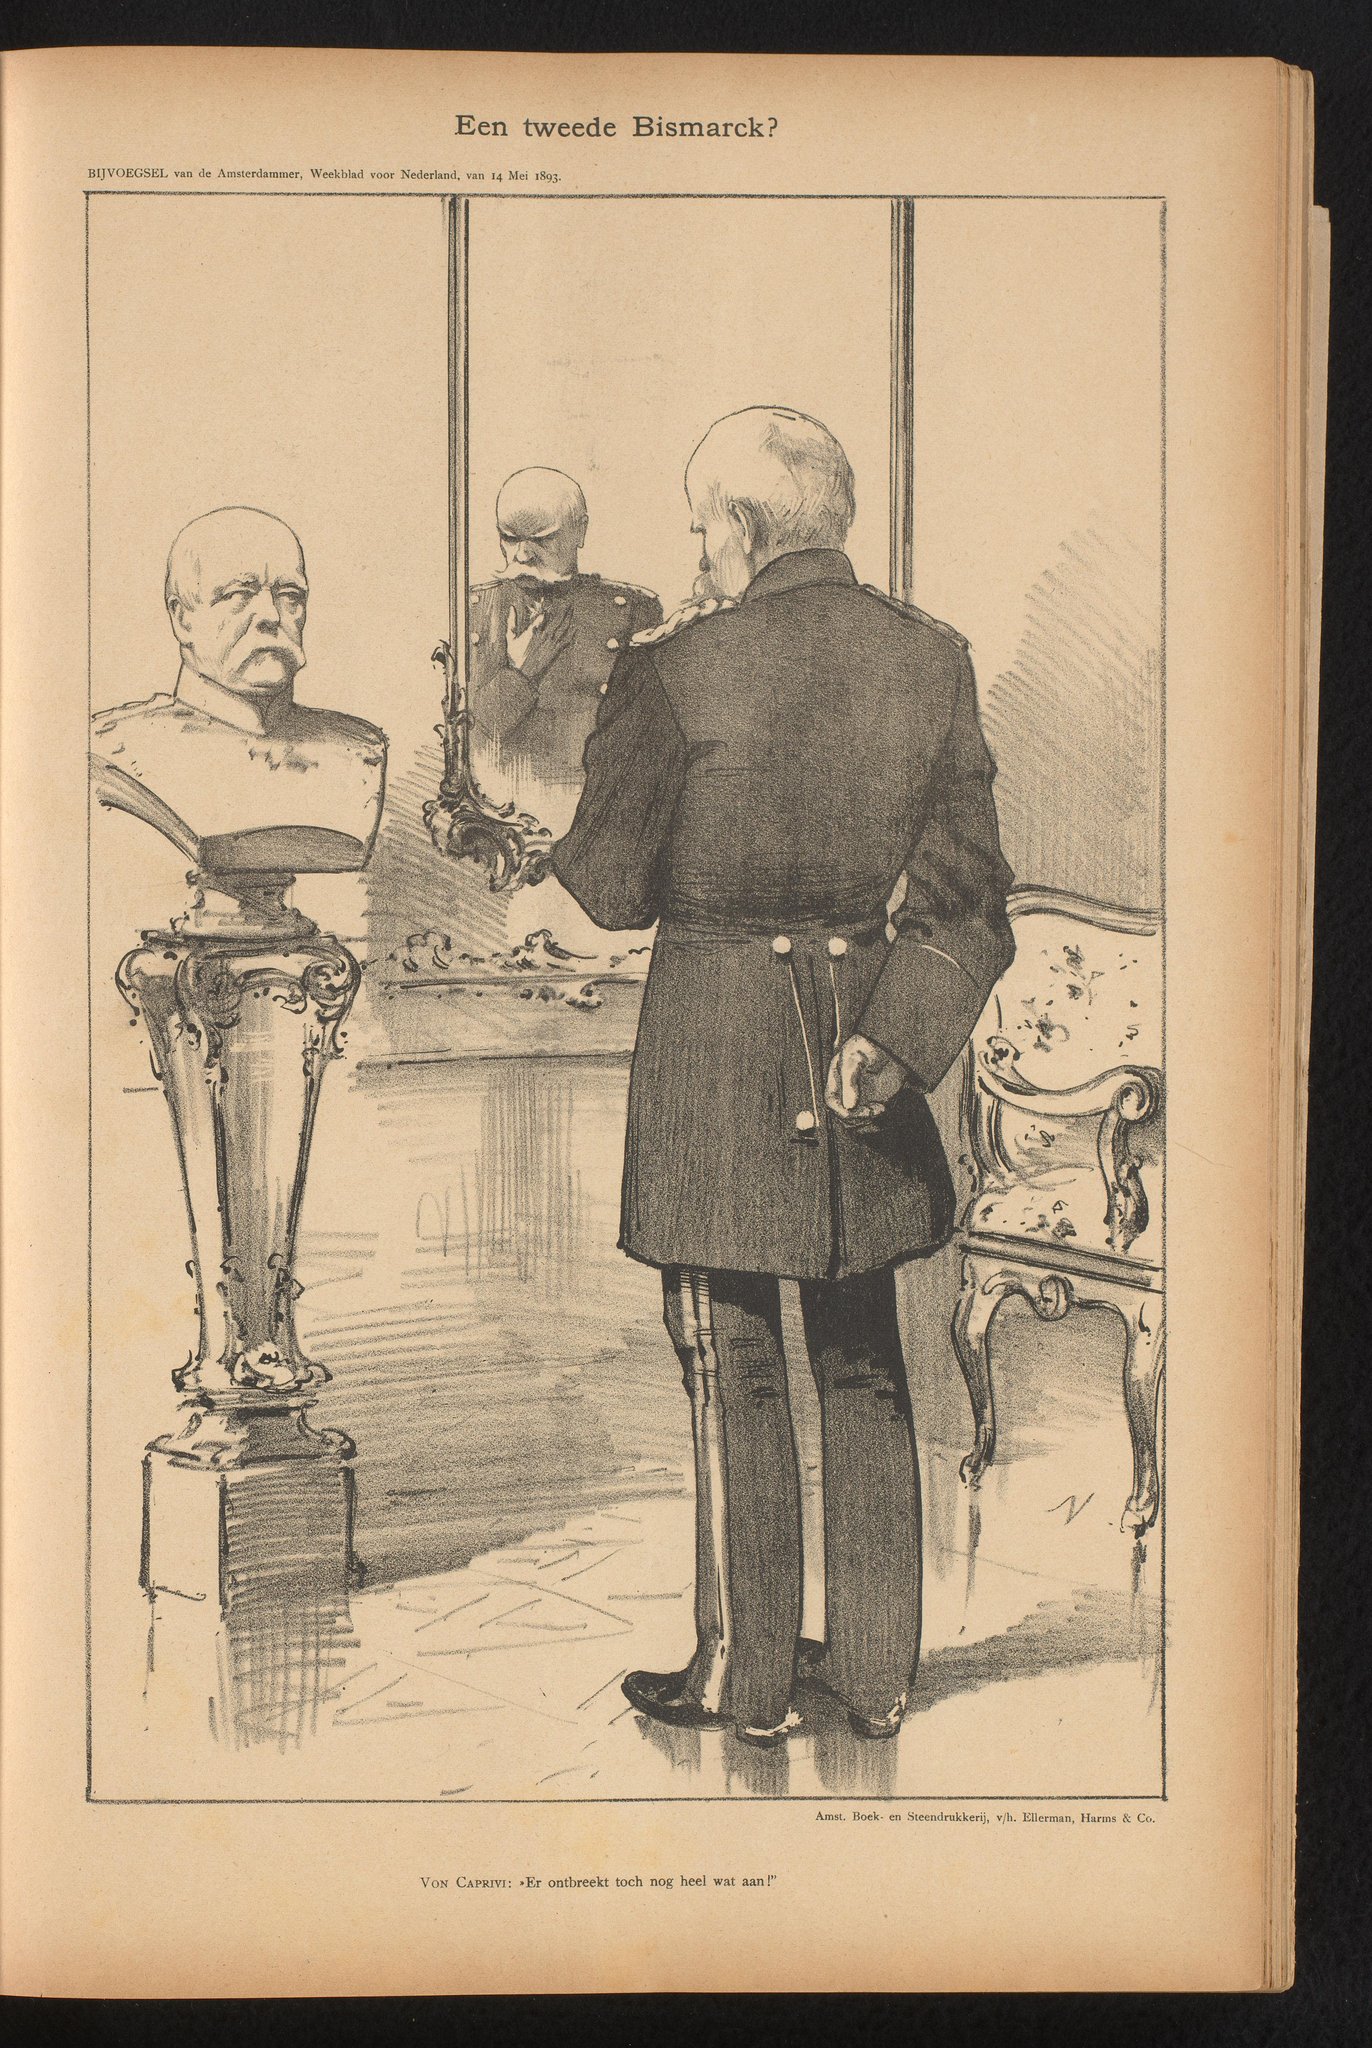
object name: cartoon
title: Een tweede Bismarck?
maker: johan braakensiek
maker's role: draughtsman, print maker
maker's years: 1858-1940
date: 1893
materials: paper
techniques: lithograph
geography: amsterdam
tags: poland, politician, looking in the mirror; contemplation of own beauty, political caricatures and satires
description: De Duitse rijkskanselier Leo von Caprivi staande voor een spiegel vergelijkt zichzelf met een buste van kanselier Otto von Bismarck.